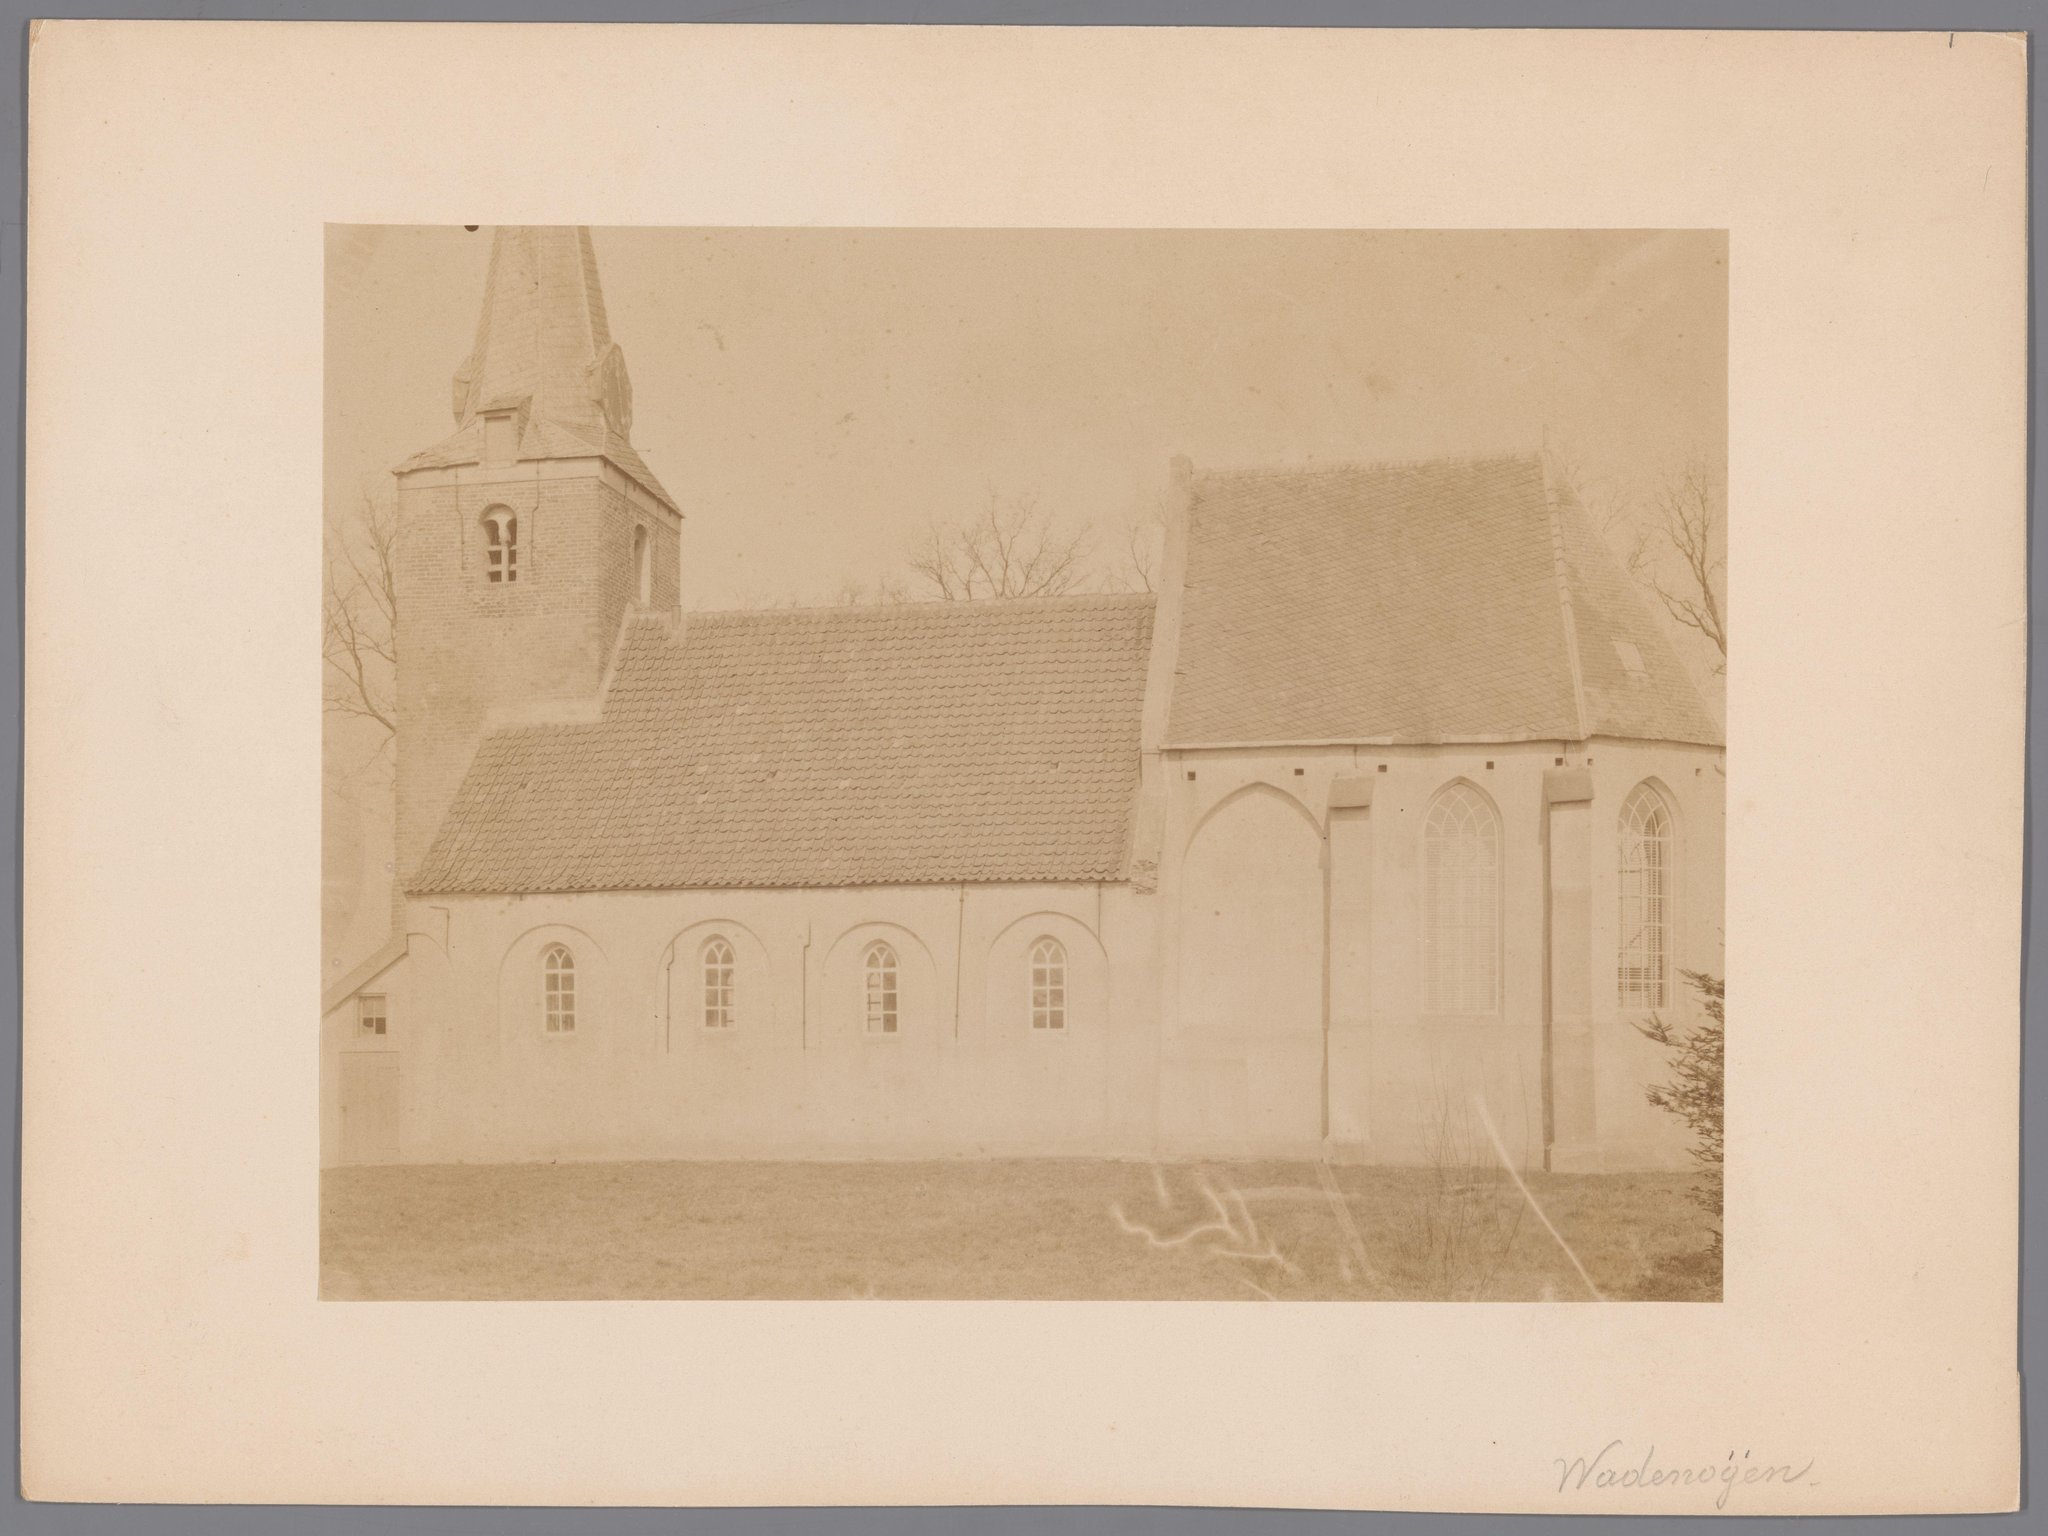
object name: photograph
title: Gezicht op de Hervormde Kerk te Wadenoijen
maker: anoniem (monumentenzorg)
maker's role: fotograaf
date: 1893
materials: cardboard, photographic support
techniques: albumen print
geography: wadenoijen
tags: church (exterior)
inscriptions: annotation: ‘Wadenoijen ij Tiel/ Kerk v/d Ned. Herv. gemeente/ Maart 1893’, annotation: ‘Wadenoijen’